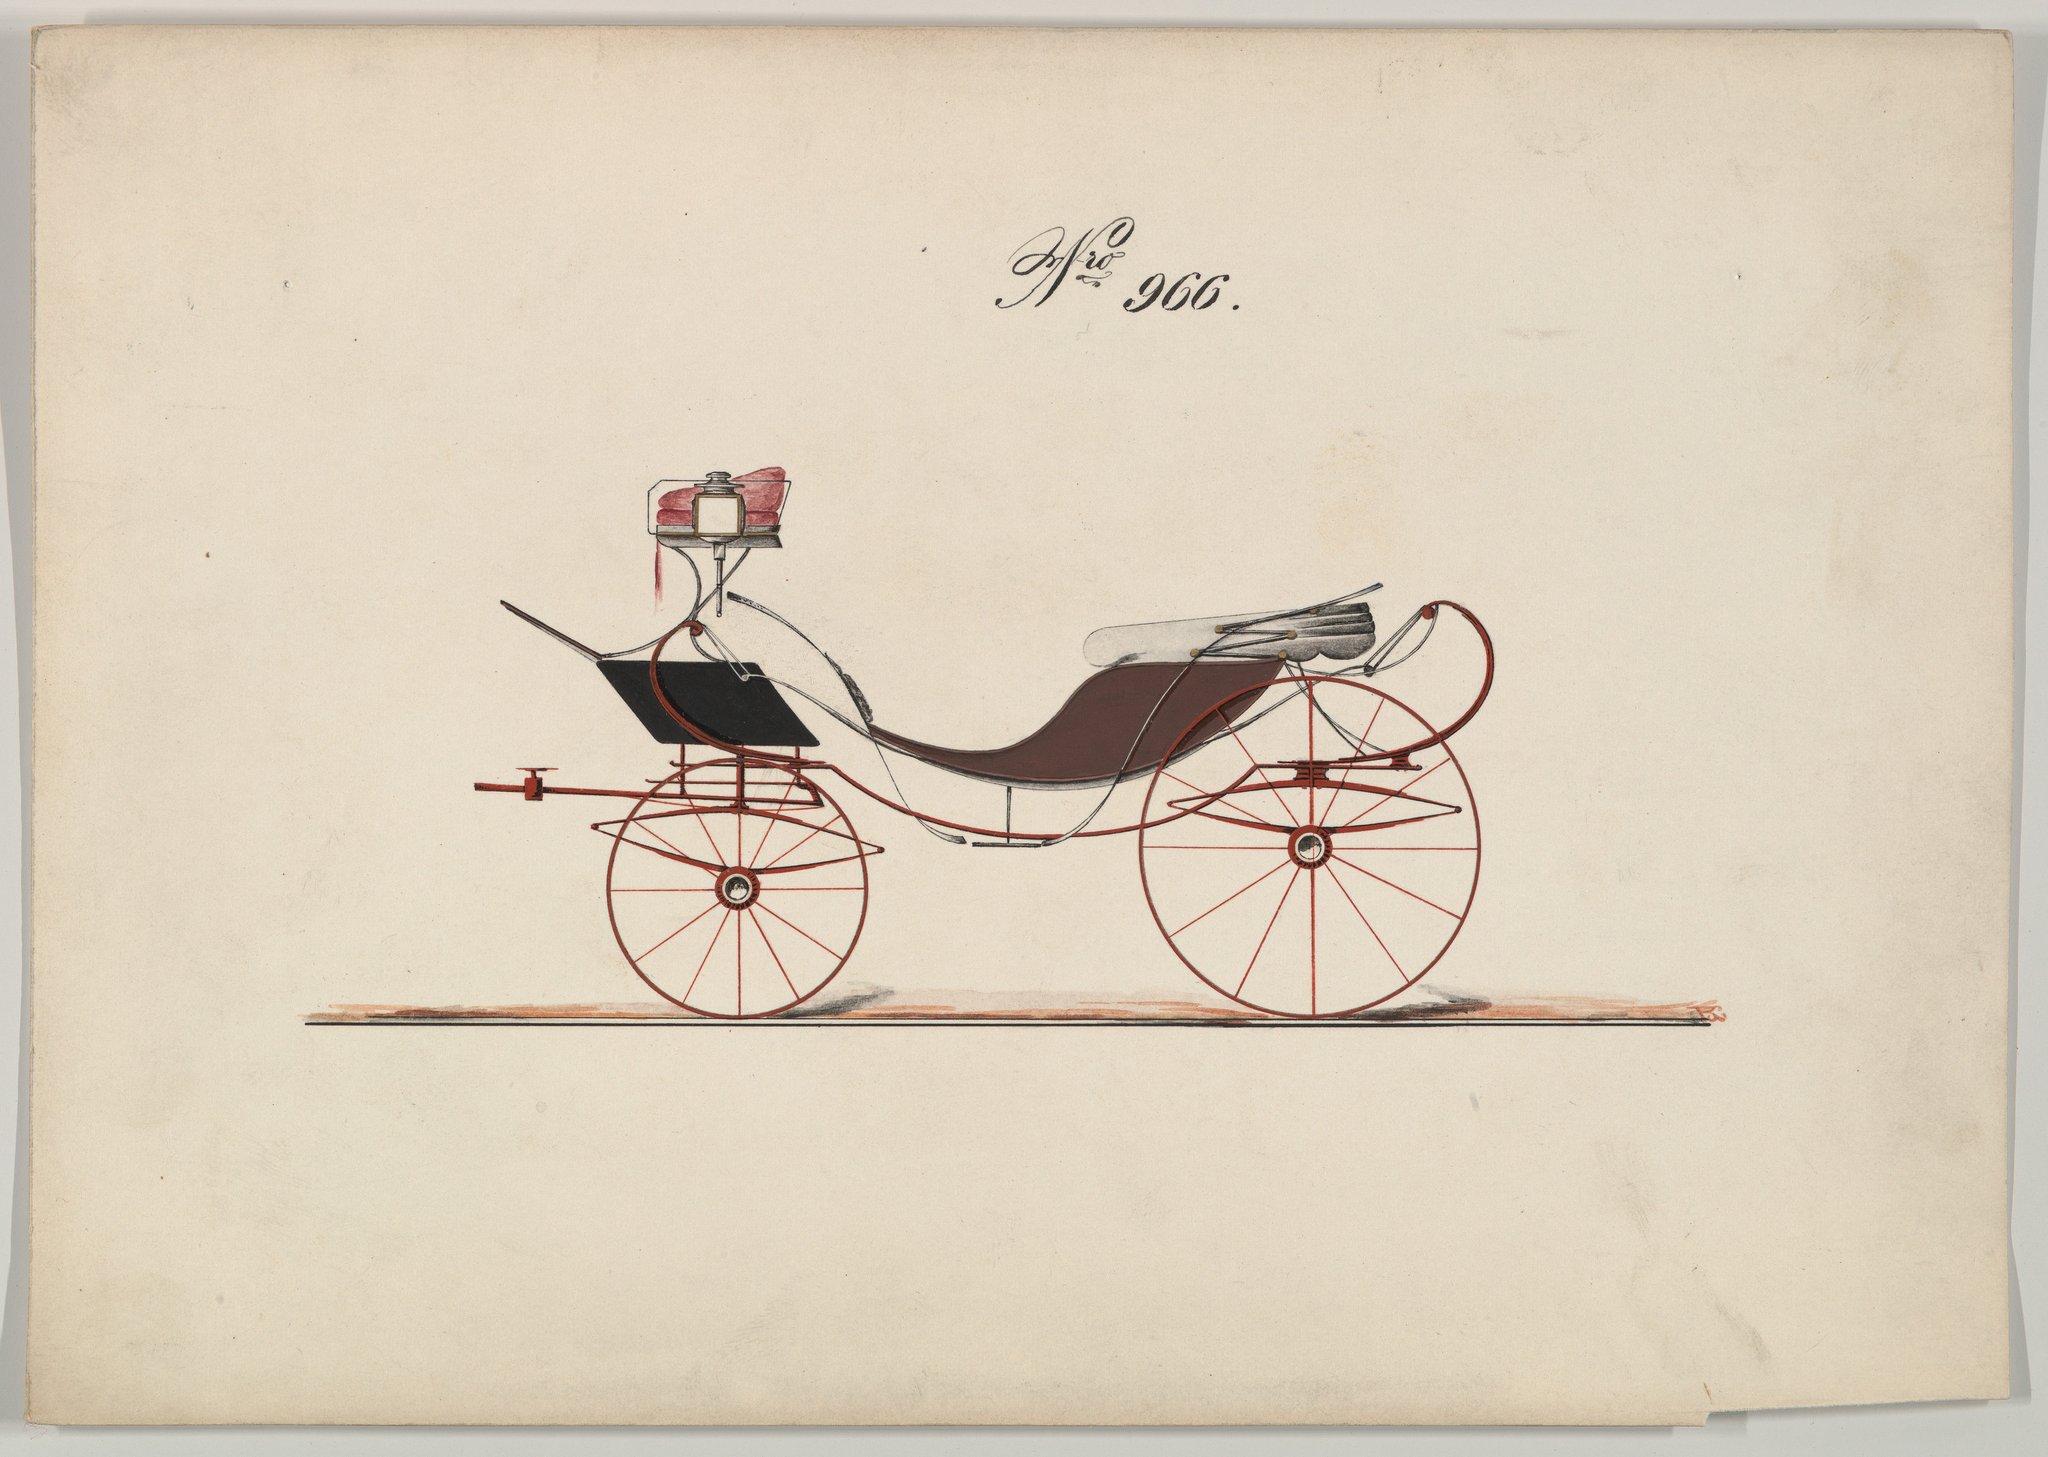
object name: drawing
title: Eight Spring Victoria #966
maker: brewster & co.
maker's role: manufacturer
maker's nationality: american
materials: gouache, gum arabic, ink, watercolor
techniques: pen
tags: carriages